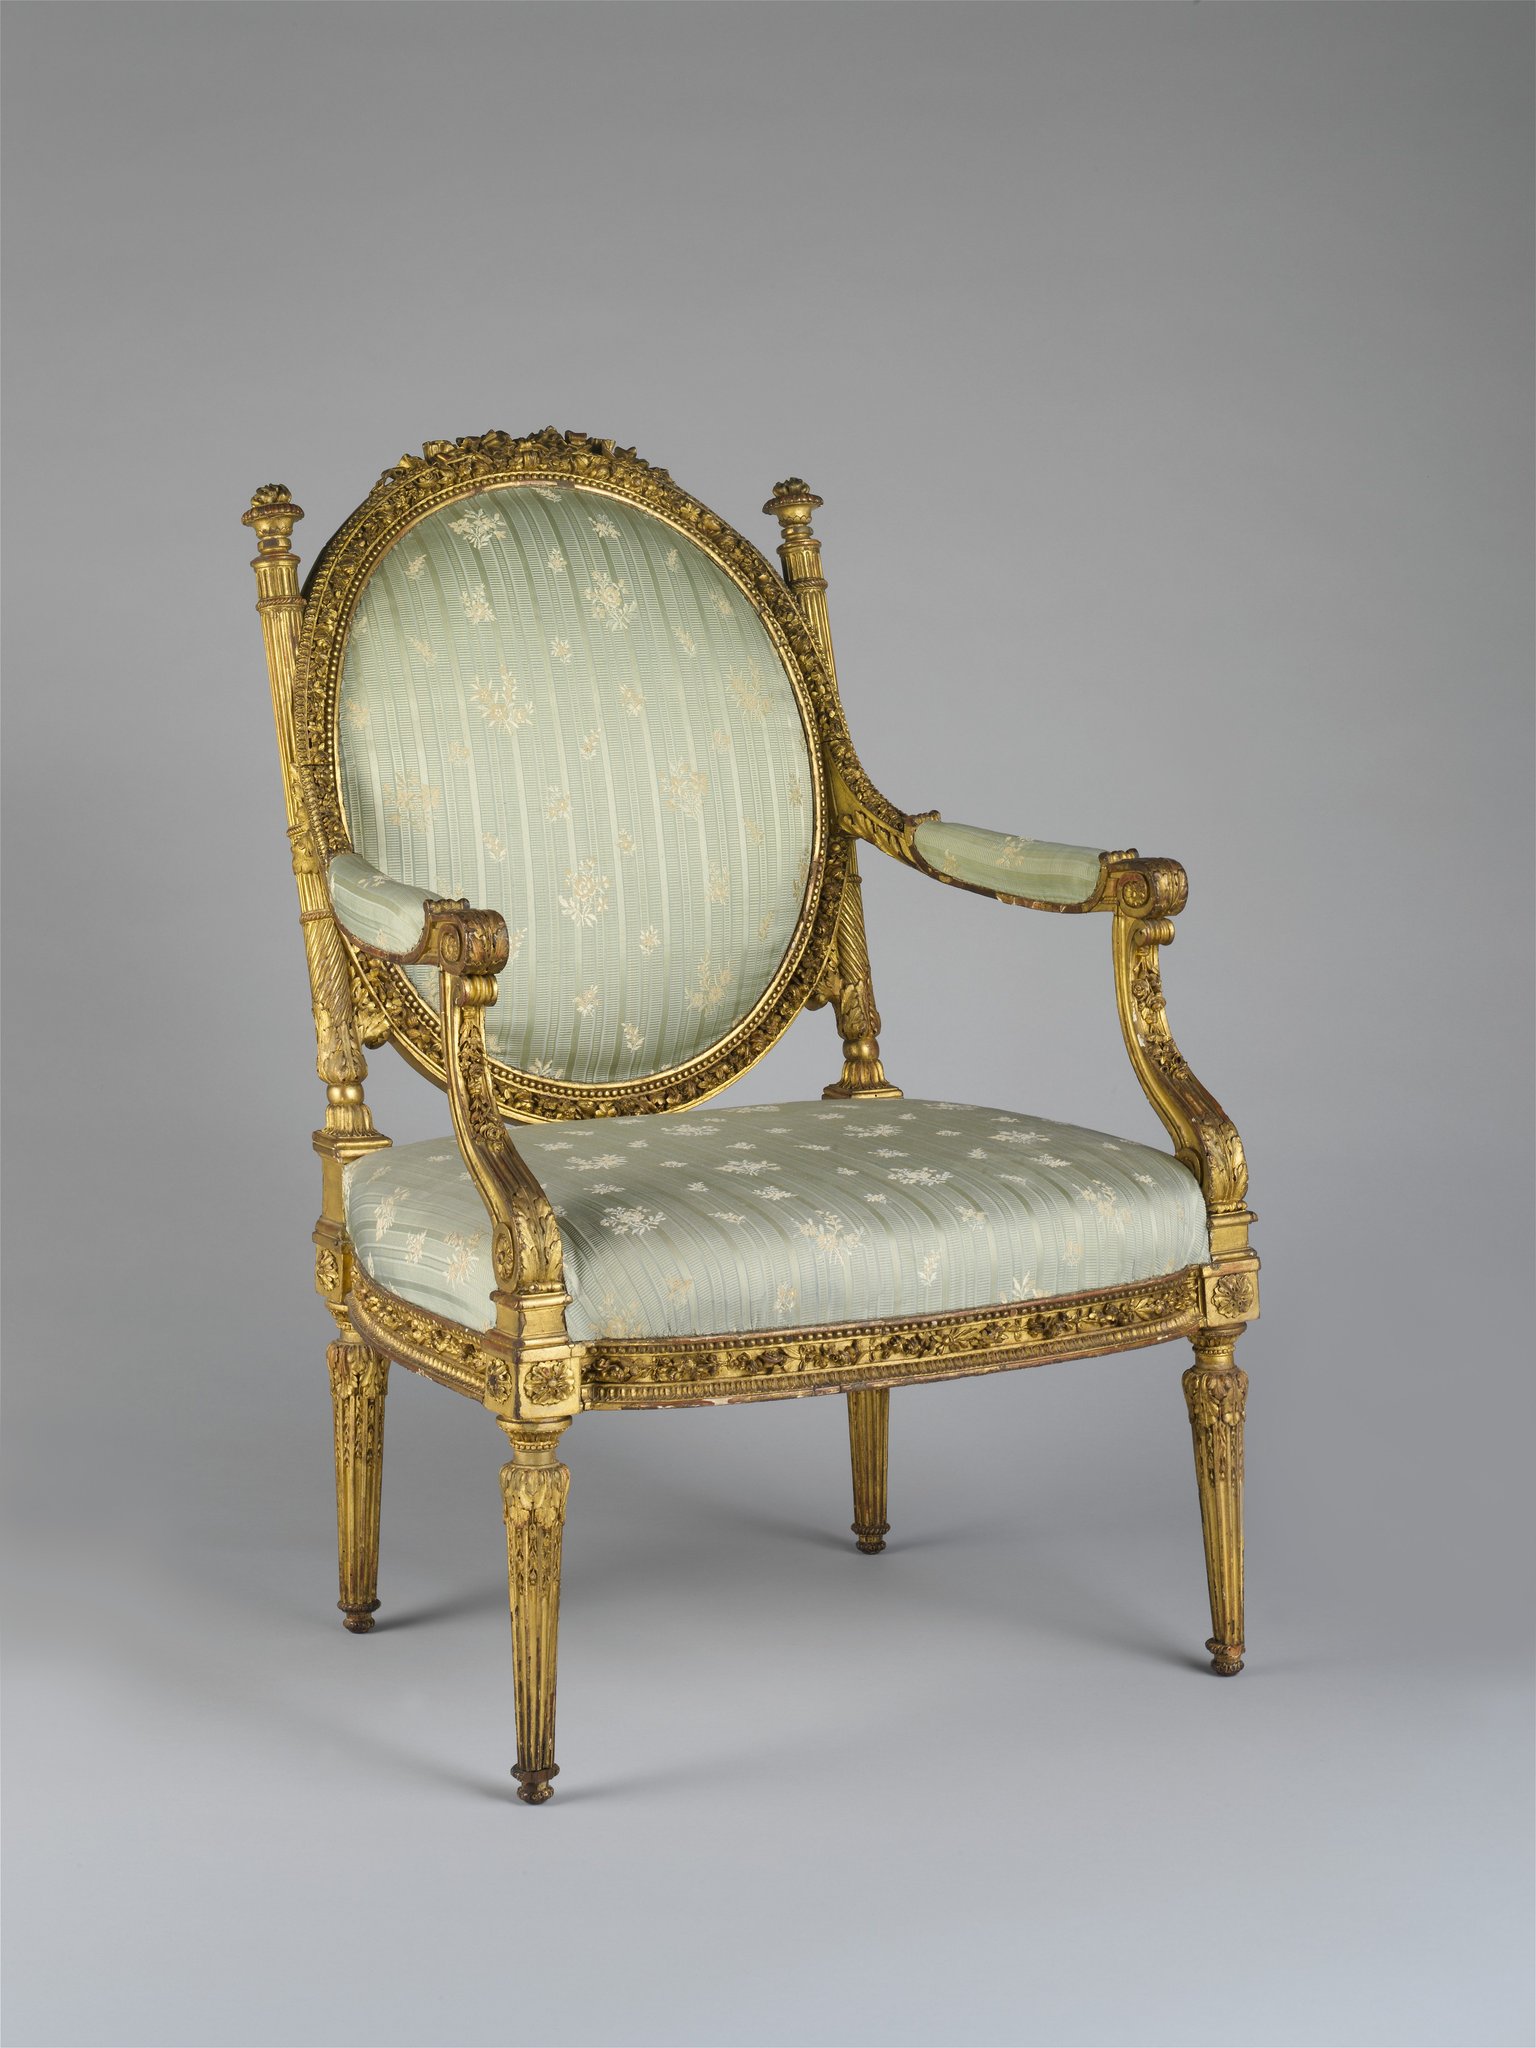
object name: armchair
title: Armchair (Fauteuil à la reine)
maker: georges jacob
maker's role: maker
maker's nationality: french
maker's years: 1739-1814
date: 1785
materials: wood, silk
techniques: carving, gilding